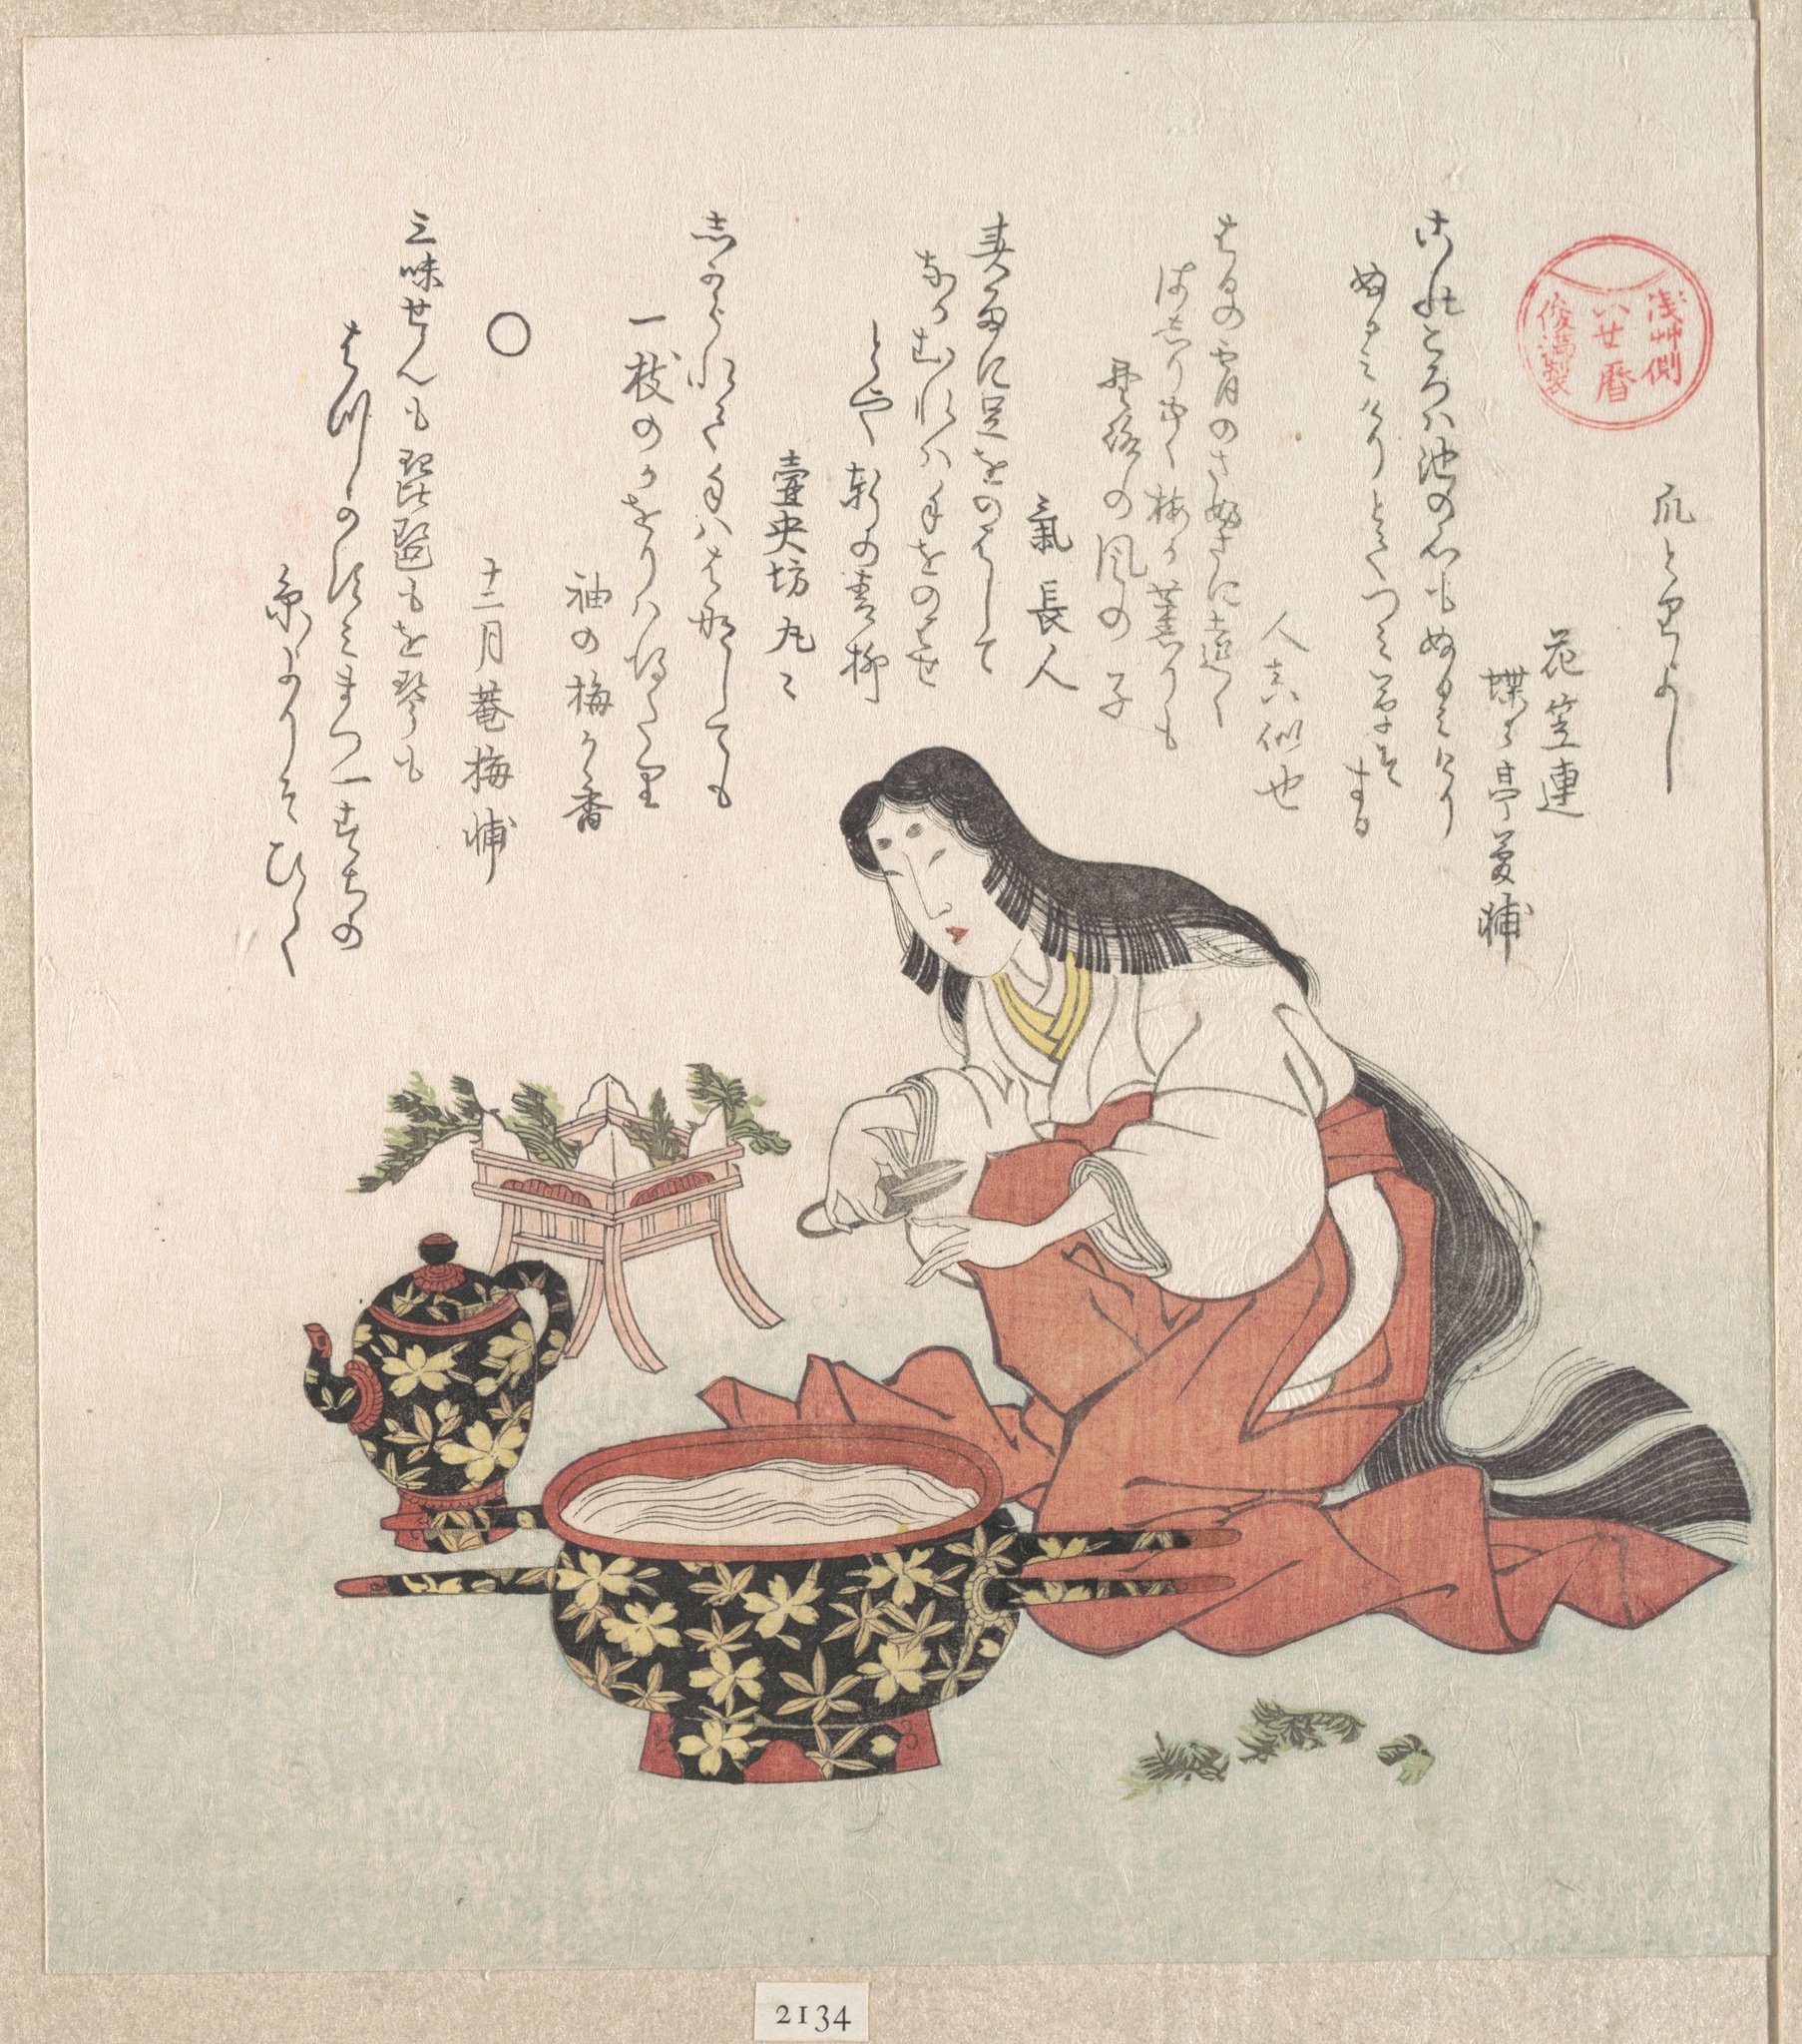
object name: print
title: Woman Cutting Her Nails after GatHering Herbs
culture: japanese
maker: kubo shunman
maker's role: artist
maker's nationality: japanese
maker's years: 1757-1820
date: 1801-1900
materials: ink, paper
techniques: surimono, woodblock print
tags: women